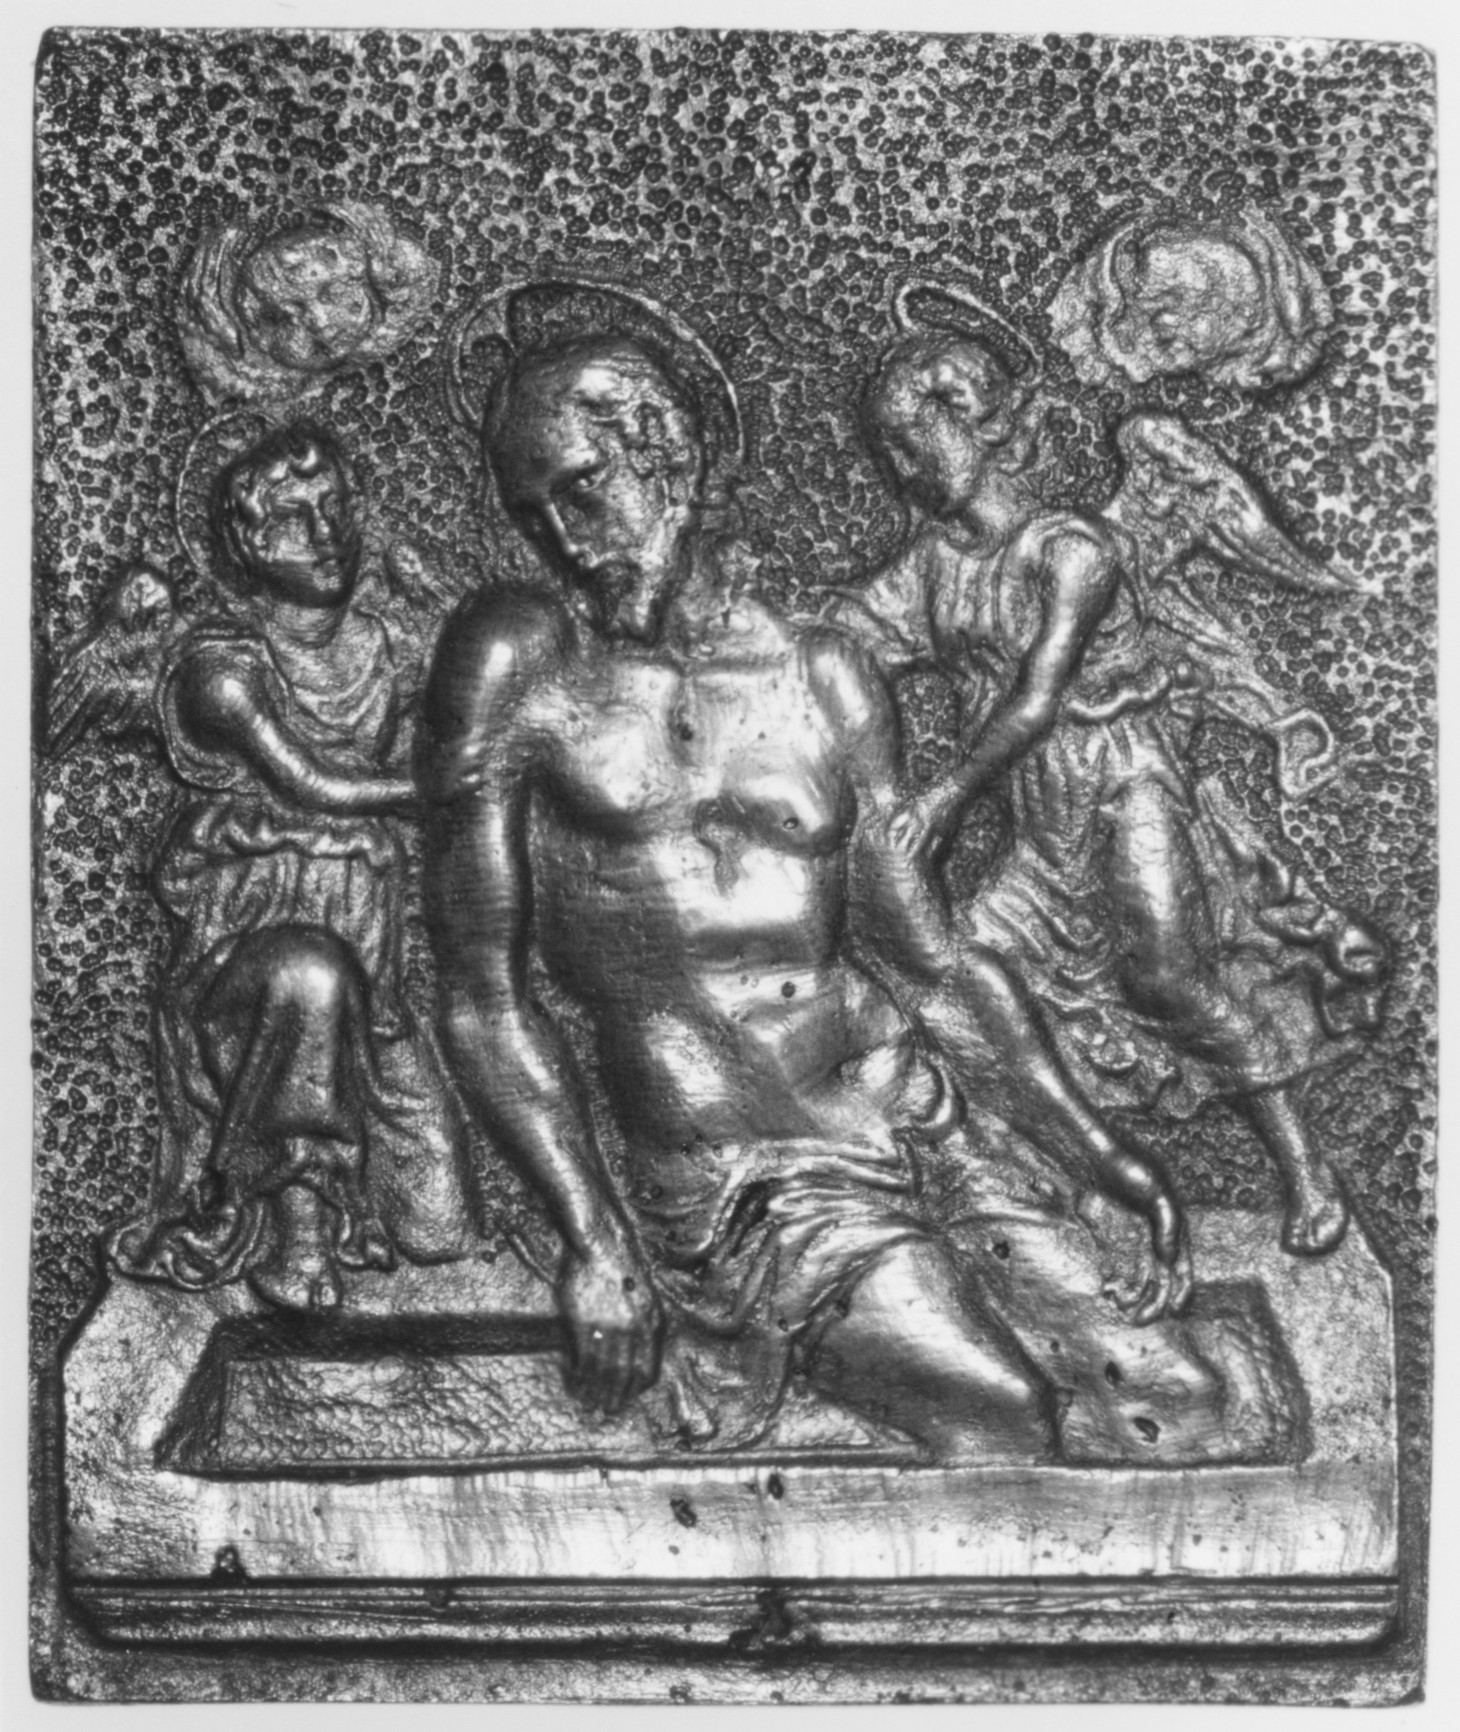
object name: plaquette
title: Dead Christ Supported by Angels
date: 1501-1533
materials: bronze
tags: angels,christ,death